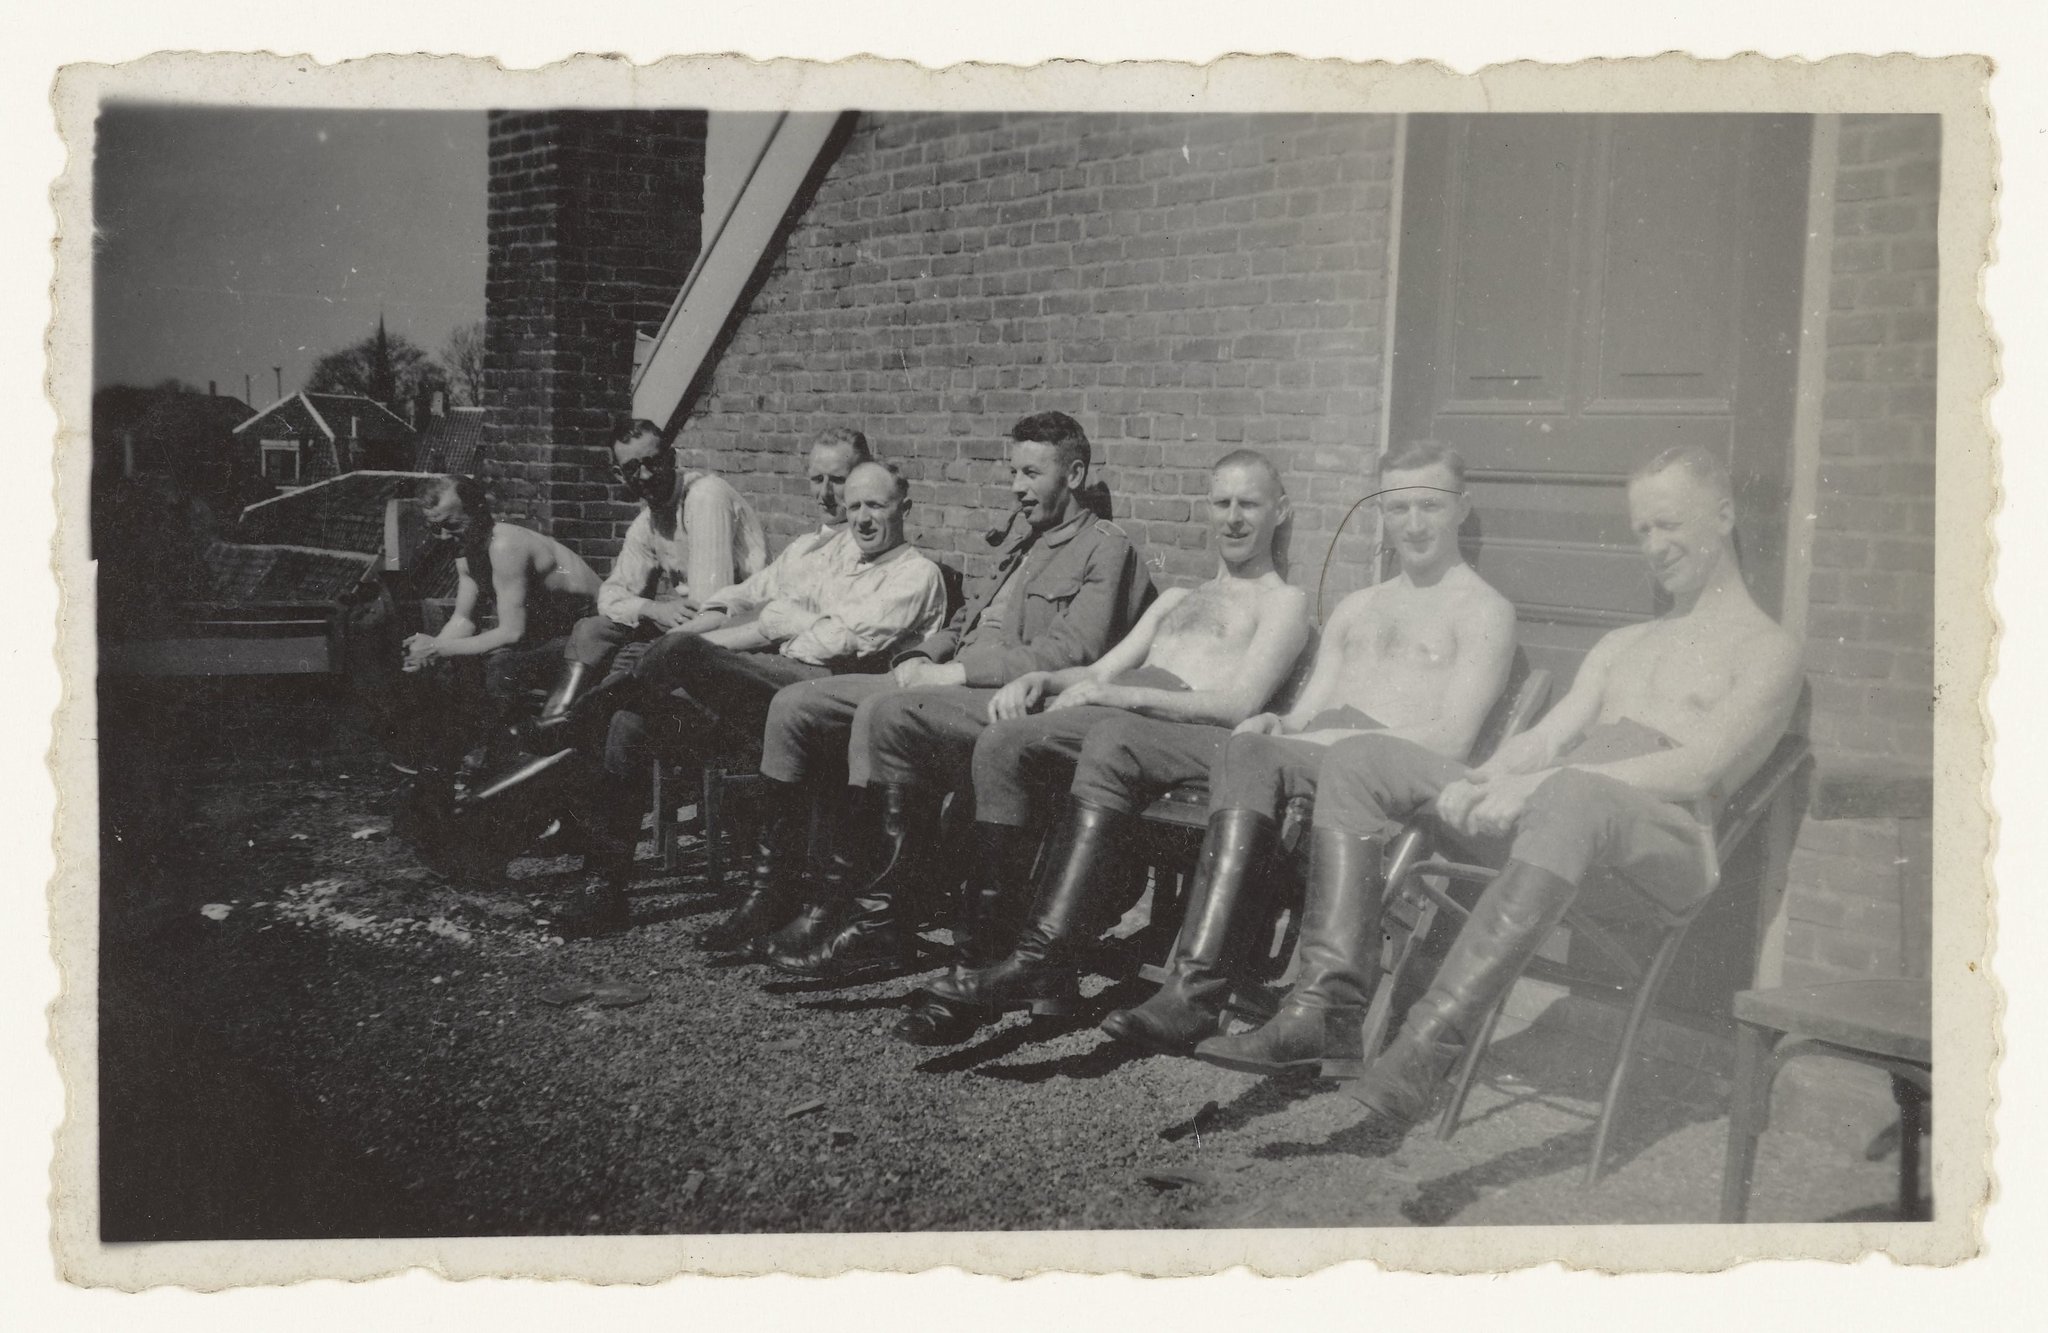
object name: photograph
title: Leden van de WA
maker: Anonymous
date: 1943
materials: photographic support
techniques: photography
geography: utrecht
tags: recreation ~ the soldier off duty, utrecht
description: Leden van (vermoedelijk) de WA, de Weerafdeling van de NSB, zitten, deels met bloot bovenlijf, in de zon voor een gebouw. Allen dragen hoge zwarte laarzen.